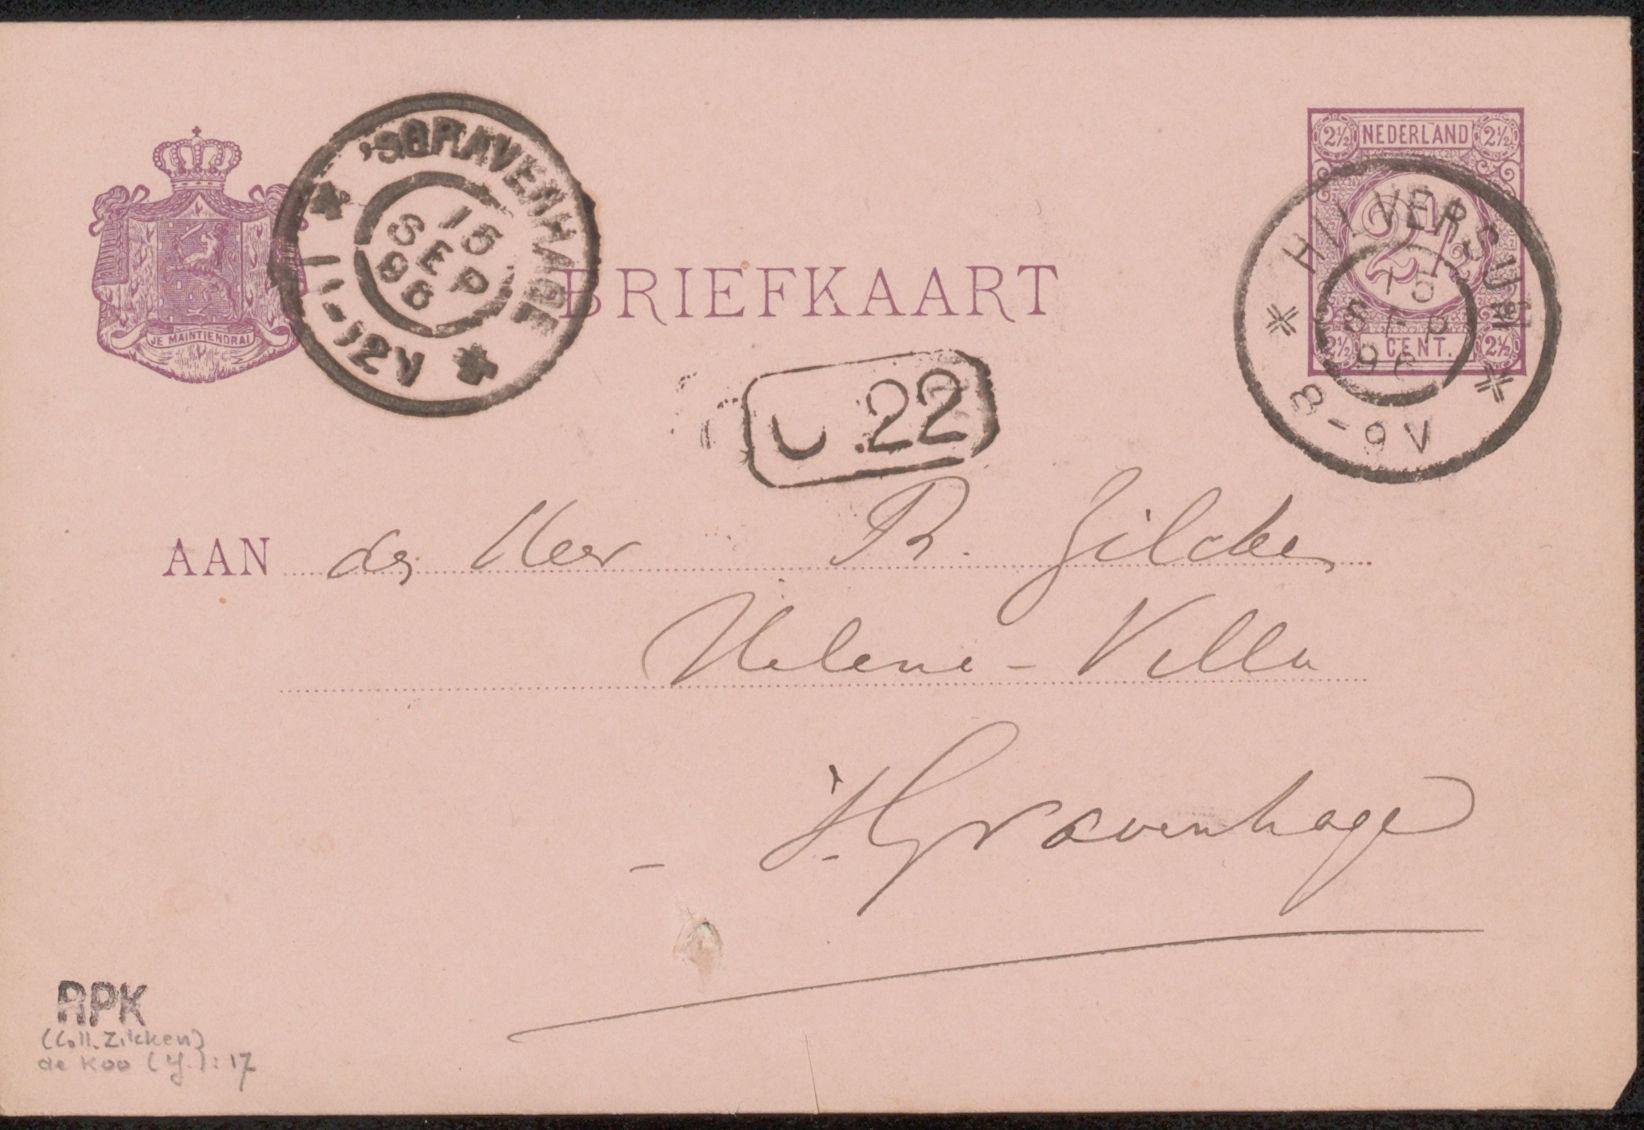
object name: postcard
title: Briefkaart aan Philip Zilcken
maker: johannes de koo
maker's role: auteur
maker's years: 1841-1909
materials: cardboard, ink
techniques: pen, writing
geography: hilversum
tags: the hague, painter, draughtsman, philip zilcken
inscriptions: collector's mark: ‘RPK’